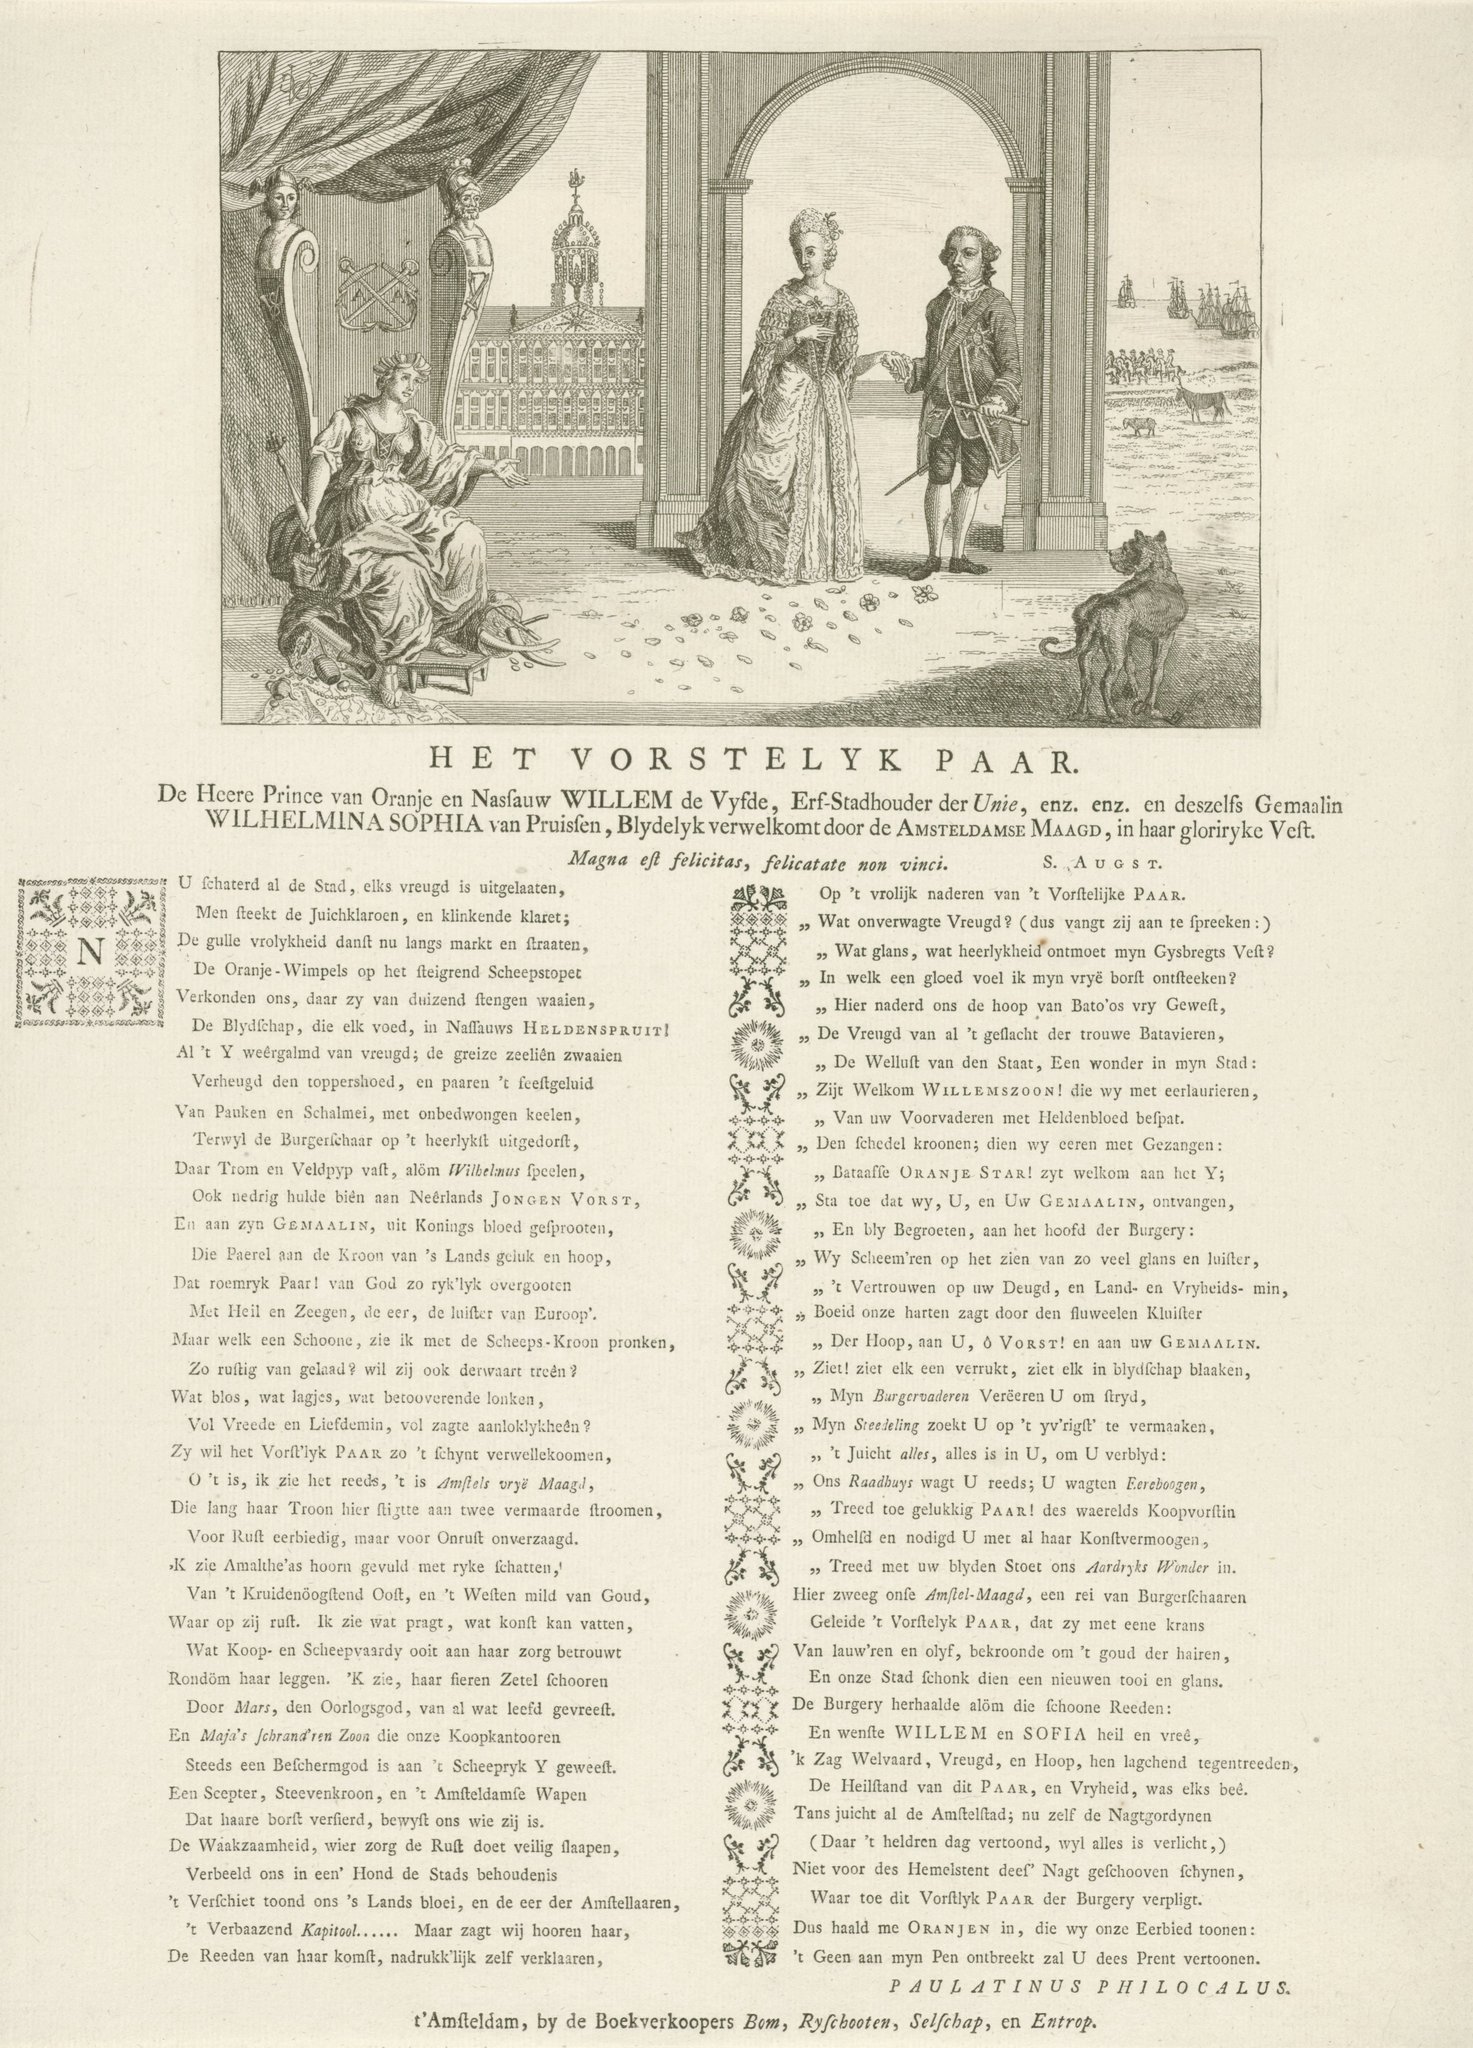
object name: print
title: Willem V en Wilhelmina van Pruisen verwelkomd door de Amsterdamse stedenmaagd, 1768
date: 1768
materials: paper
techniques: etching, letterpress printing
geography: northern netherlands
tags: the hague, william v (prince of orange), berlin, painter, draughtsman, wilhelmina of prussia (princess of orange), personification of a city, town-patron(ess), amsterdam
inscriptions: collector's mark: Lugt 2228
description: Allegorie op het bezoek van stadhouder Willem V en prinses Wilhelmina van Pruisen aan Amsterdam, 31 mei - 4 juni 1768. Het prinselijk paar staande voor een erepoort wordt verwelkomd door de Amsterdamse stedenmaagd. Rechts een hond met de poot op de sleutel van de stad. Op de achtergrond de illuminatie van het Amsterdamse Stadhuis. Op het blad onder de plaat een vers in twee kolommen, met versieringen van fileten en met het adres van verschillende boekverkopers te Amsterdam.